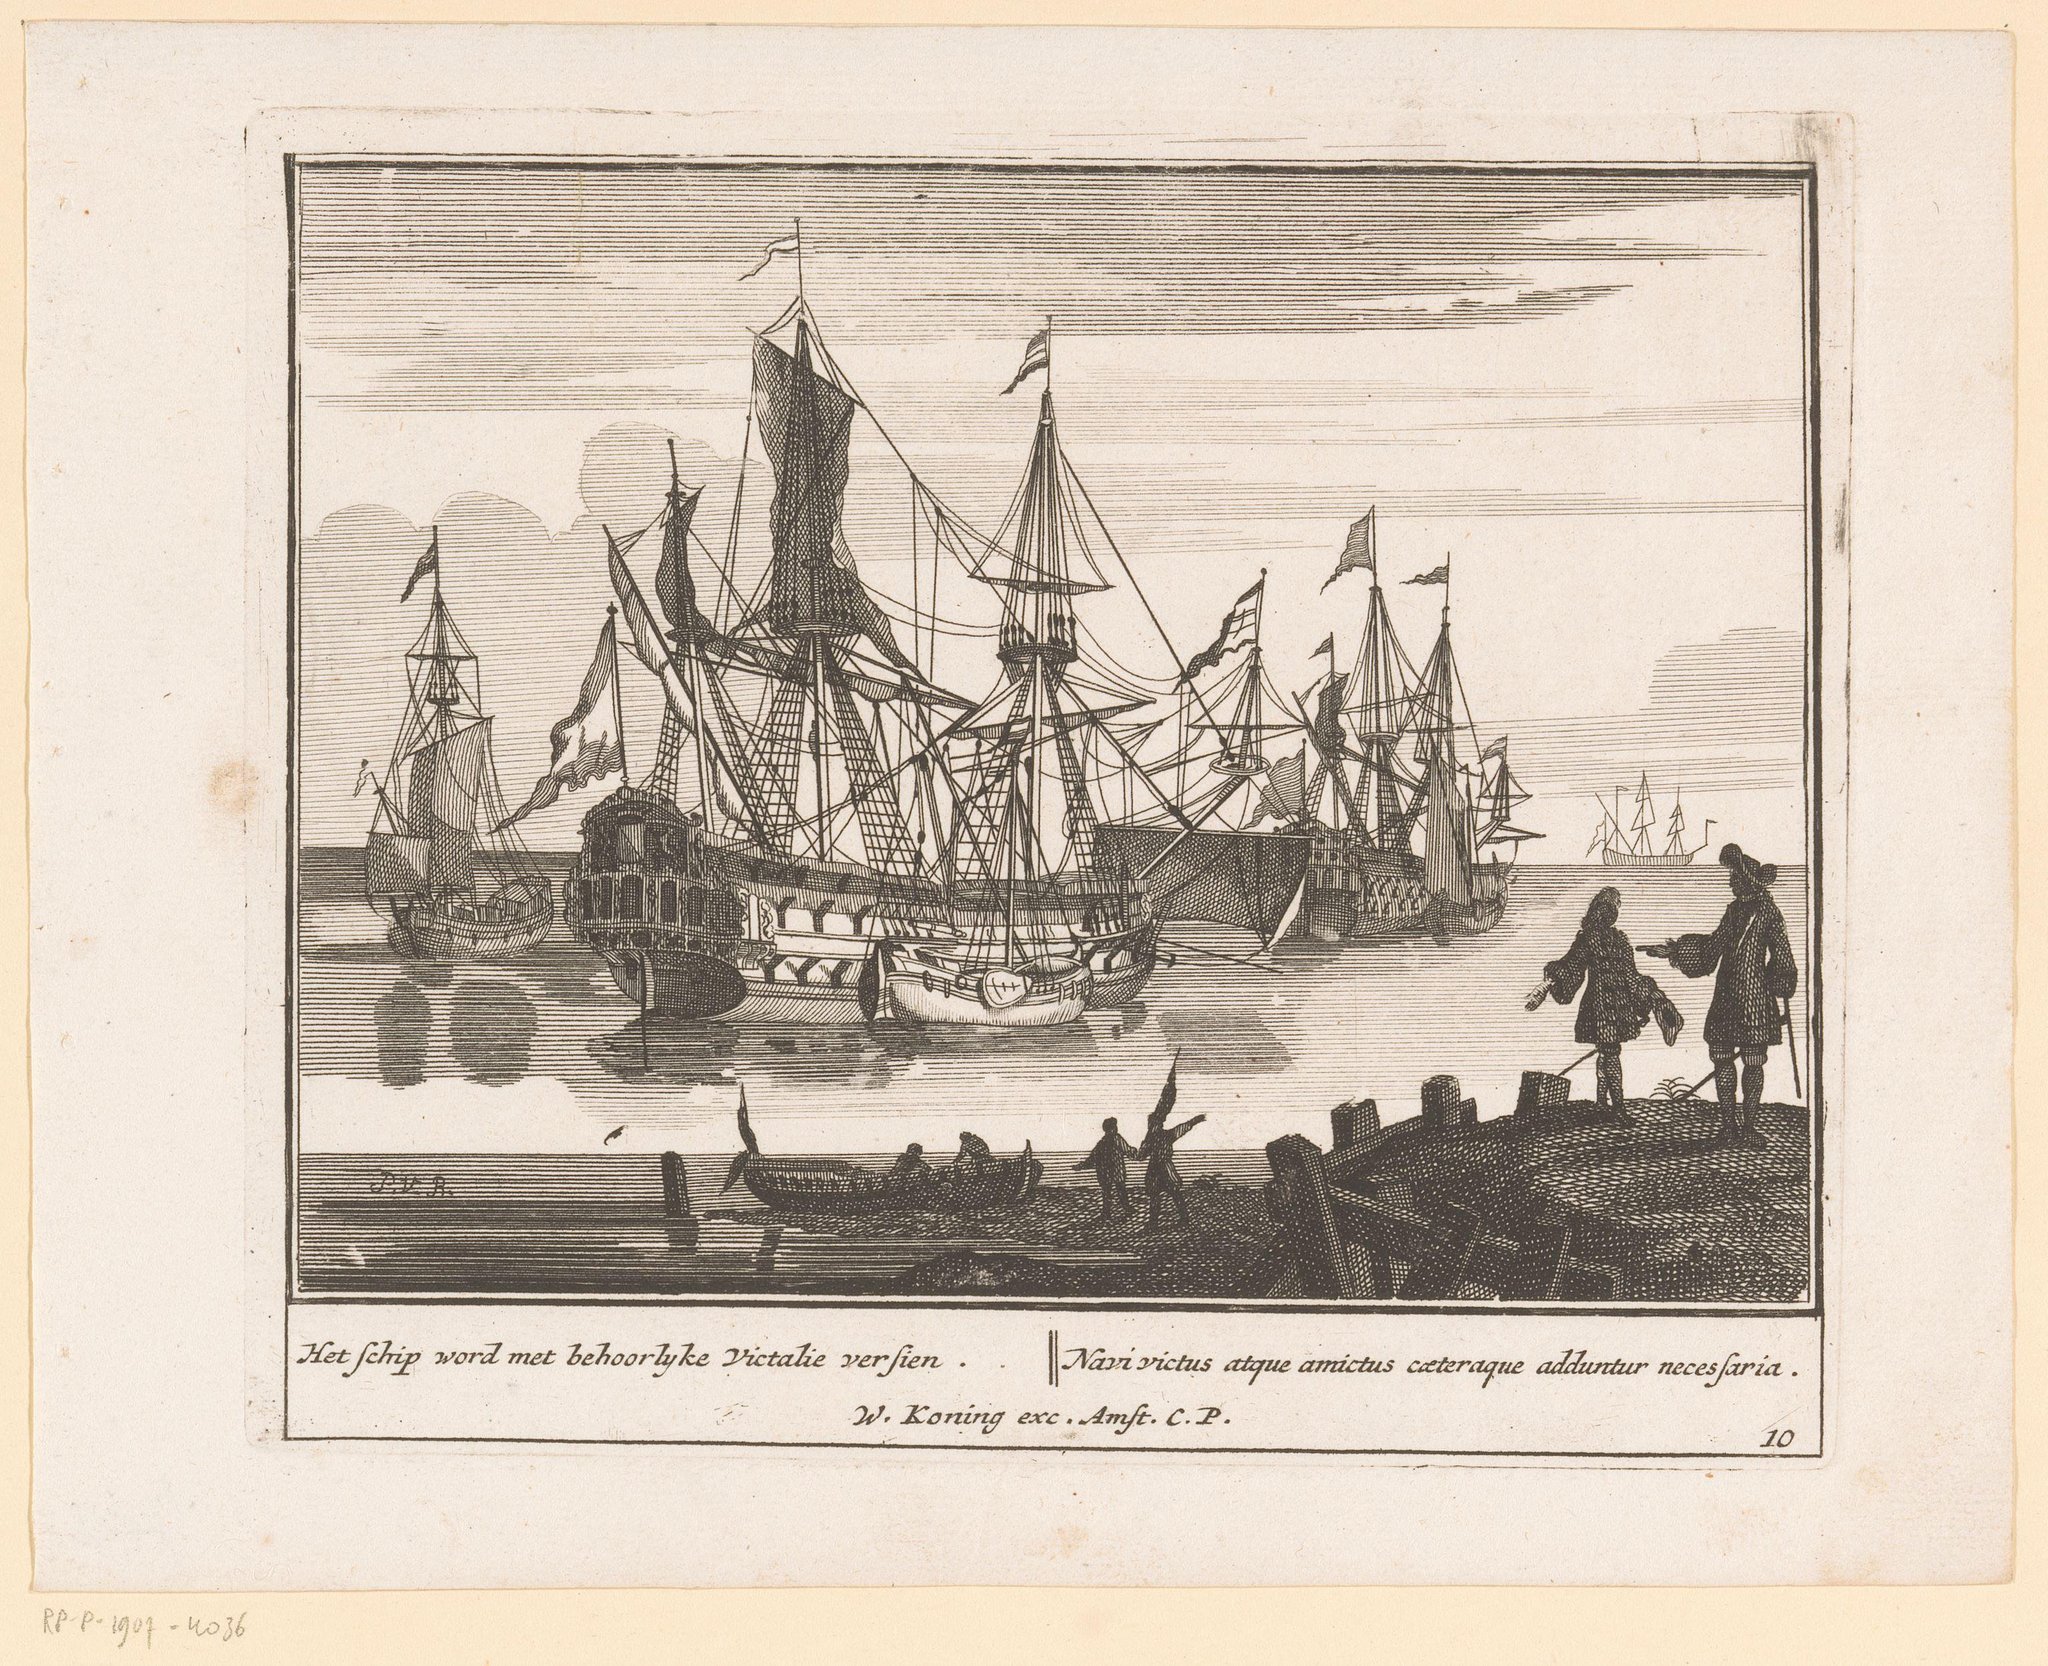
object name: print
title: Navigiorum Aedificatio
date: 1717-1732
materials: paper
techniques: engraving, etching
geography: amsterdam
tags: shipyard, shipdock, shipbuilding industry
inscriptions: collector's mark: Lugt 2228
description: Maakt deel uit van een zestiendelige serie met verschillende schepen in aanbouw en enkele ongelukken, getiteld 'Navigiorum Aedificatio' naar prenten door Siewert van der Meulen, uitgegeven door Isaac Greve en Wilhelmus Koning.